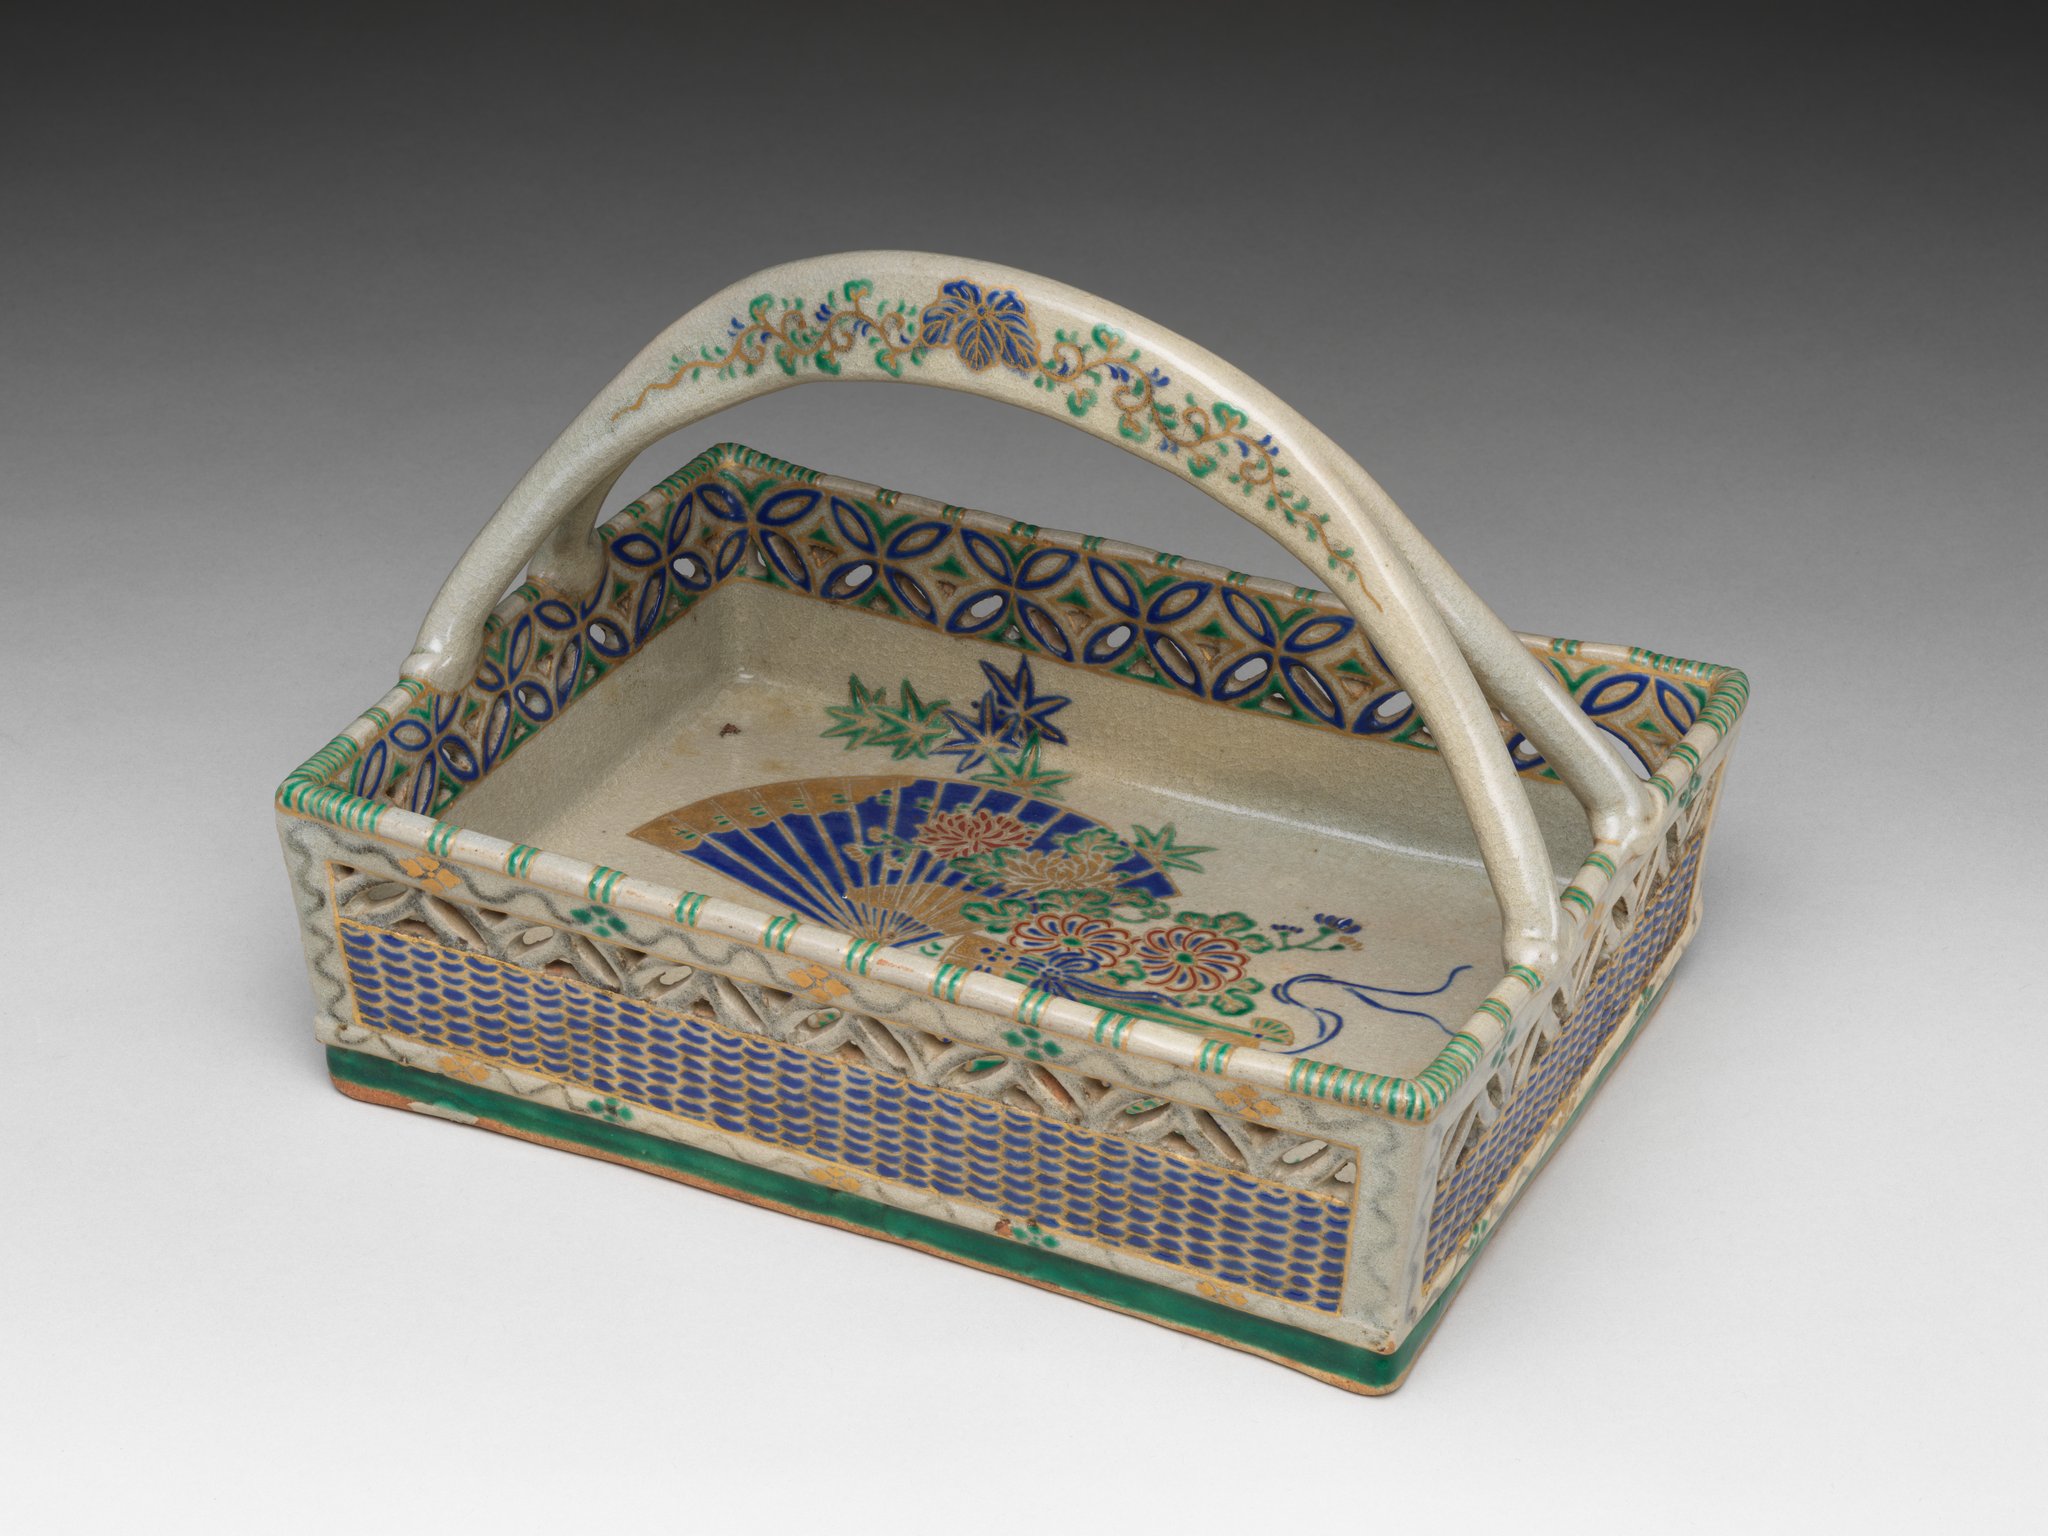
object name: basket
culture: japanese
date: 1601-1800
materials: ceramic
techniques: polychrome